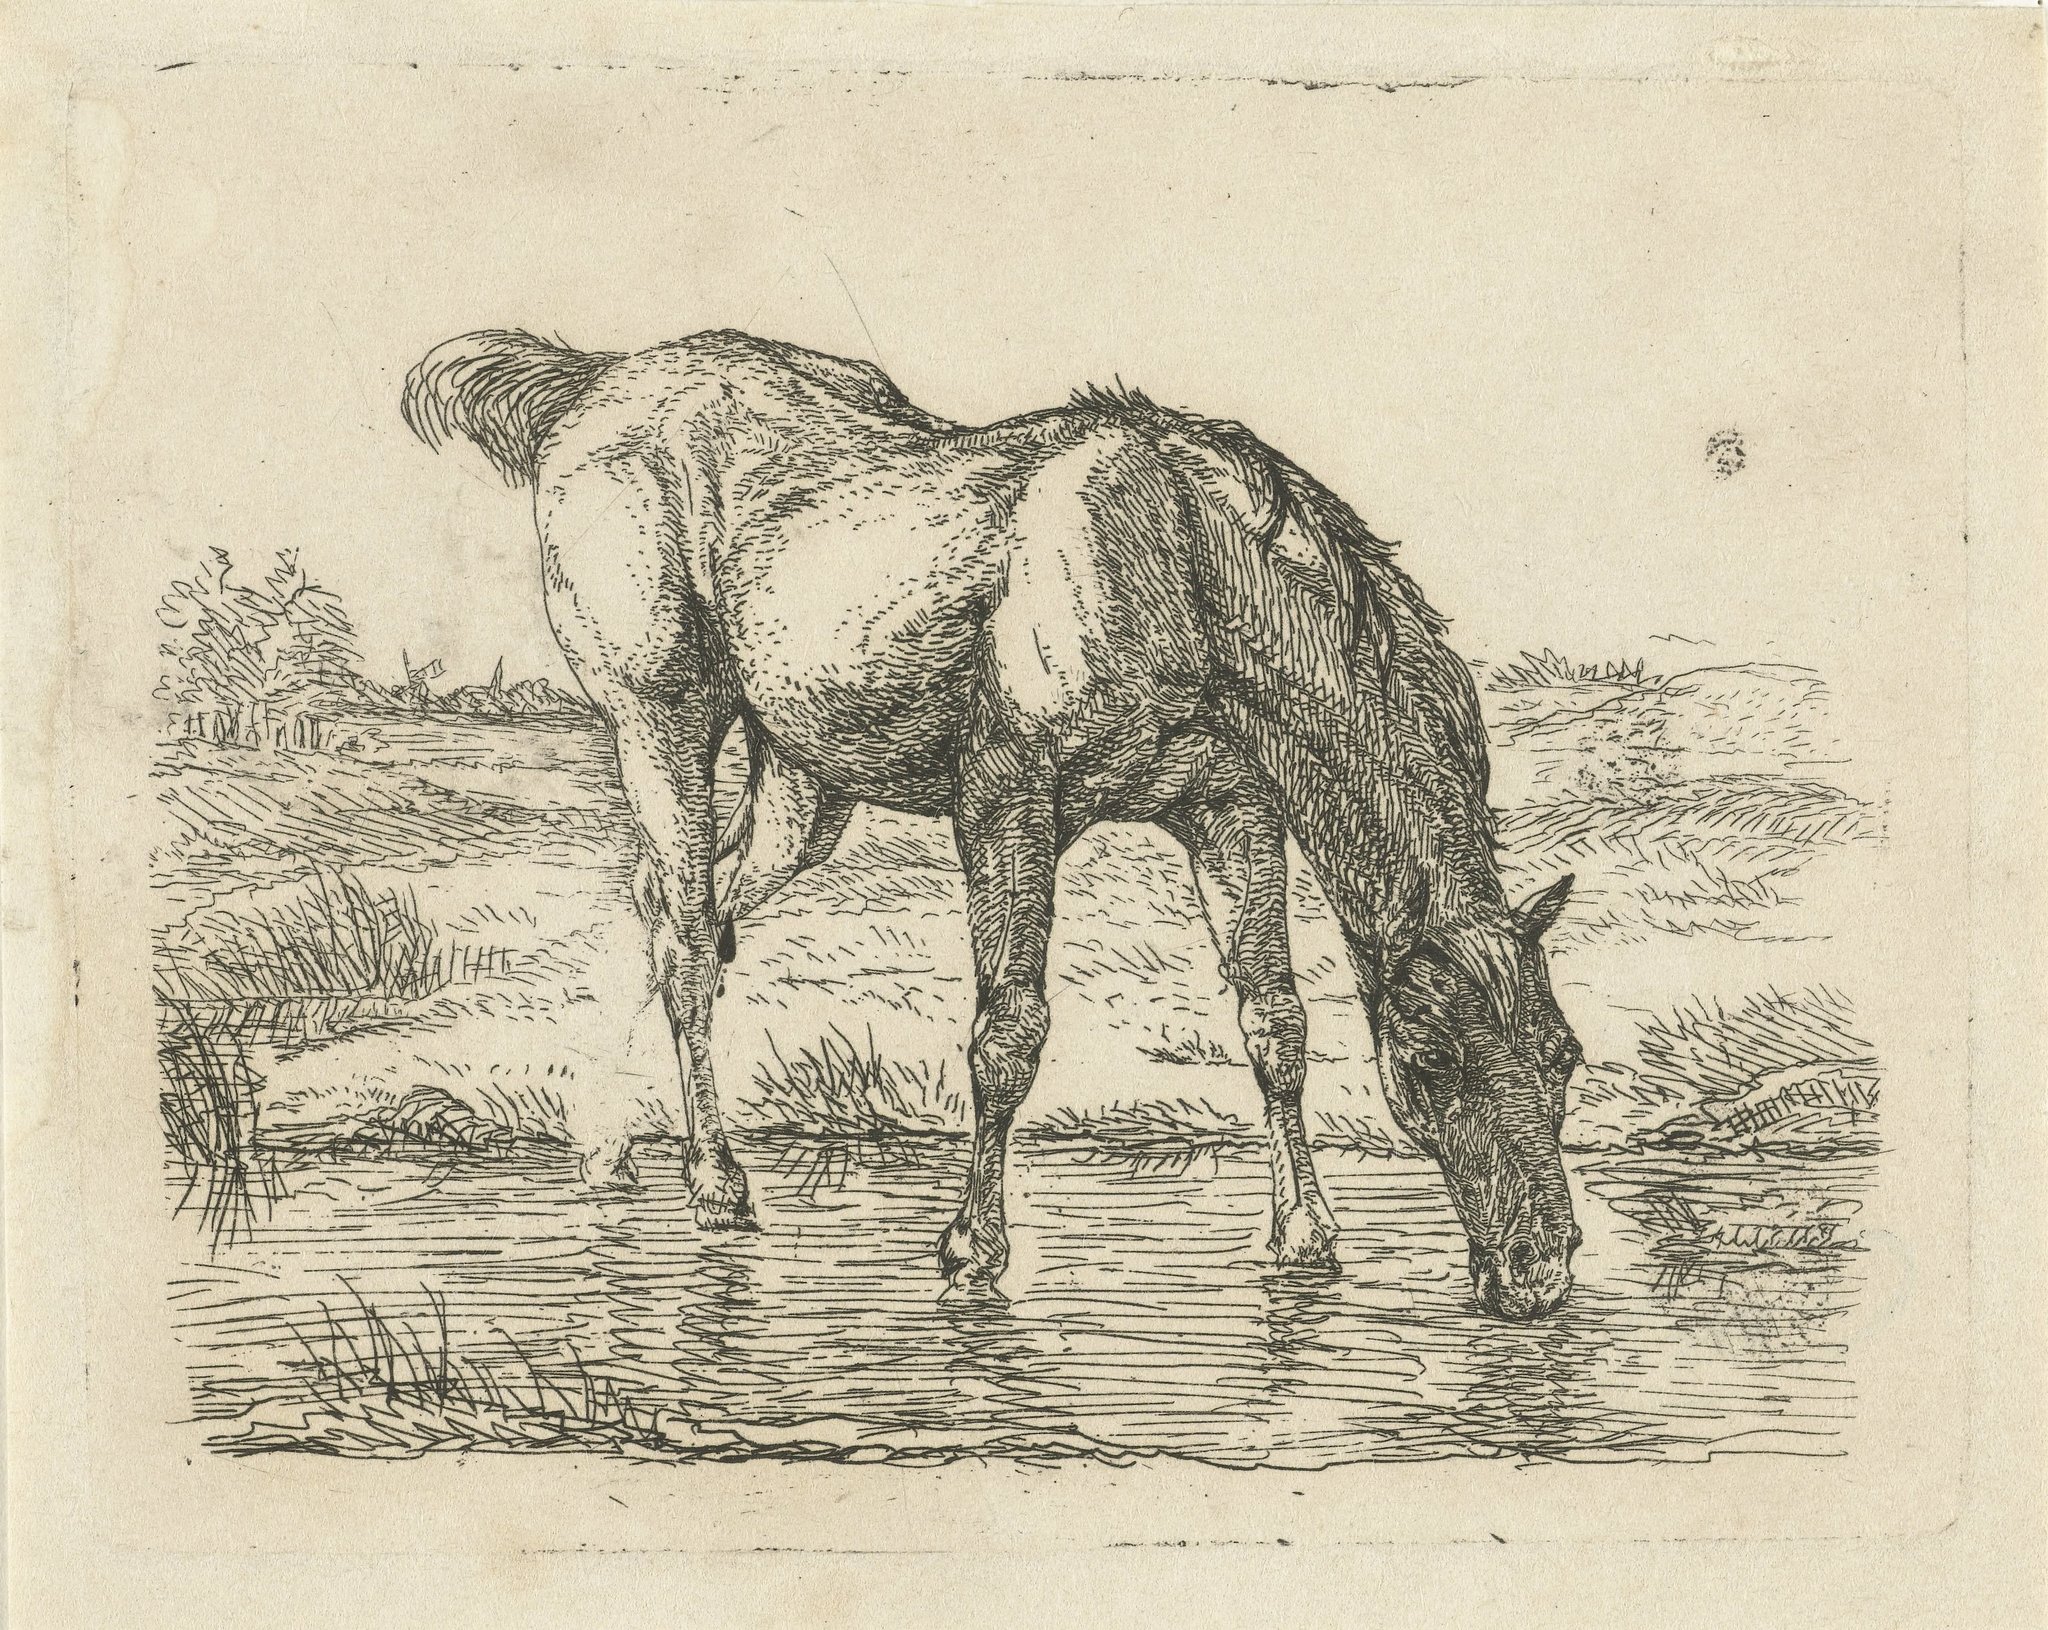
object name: print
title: Drinkend paard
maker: jan dasveldt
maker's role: draughtsman, print maker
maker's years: 1770-1855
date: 1780-1855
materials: paper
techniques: etching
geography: amsterdam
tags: horses and kindred animals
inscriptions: collector's mark: Lugt 2228